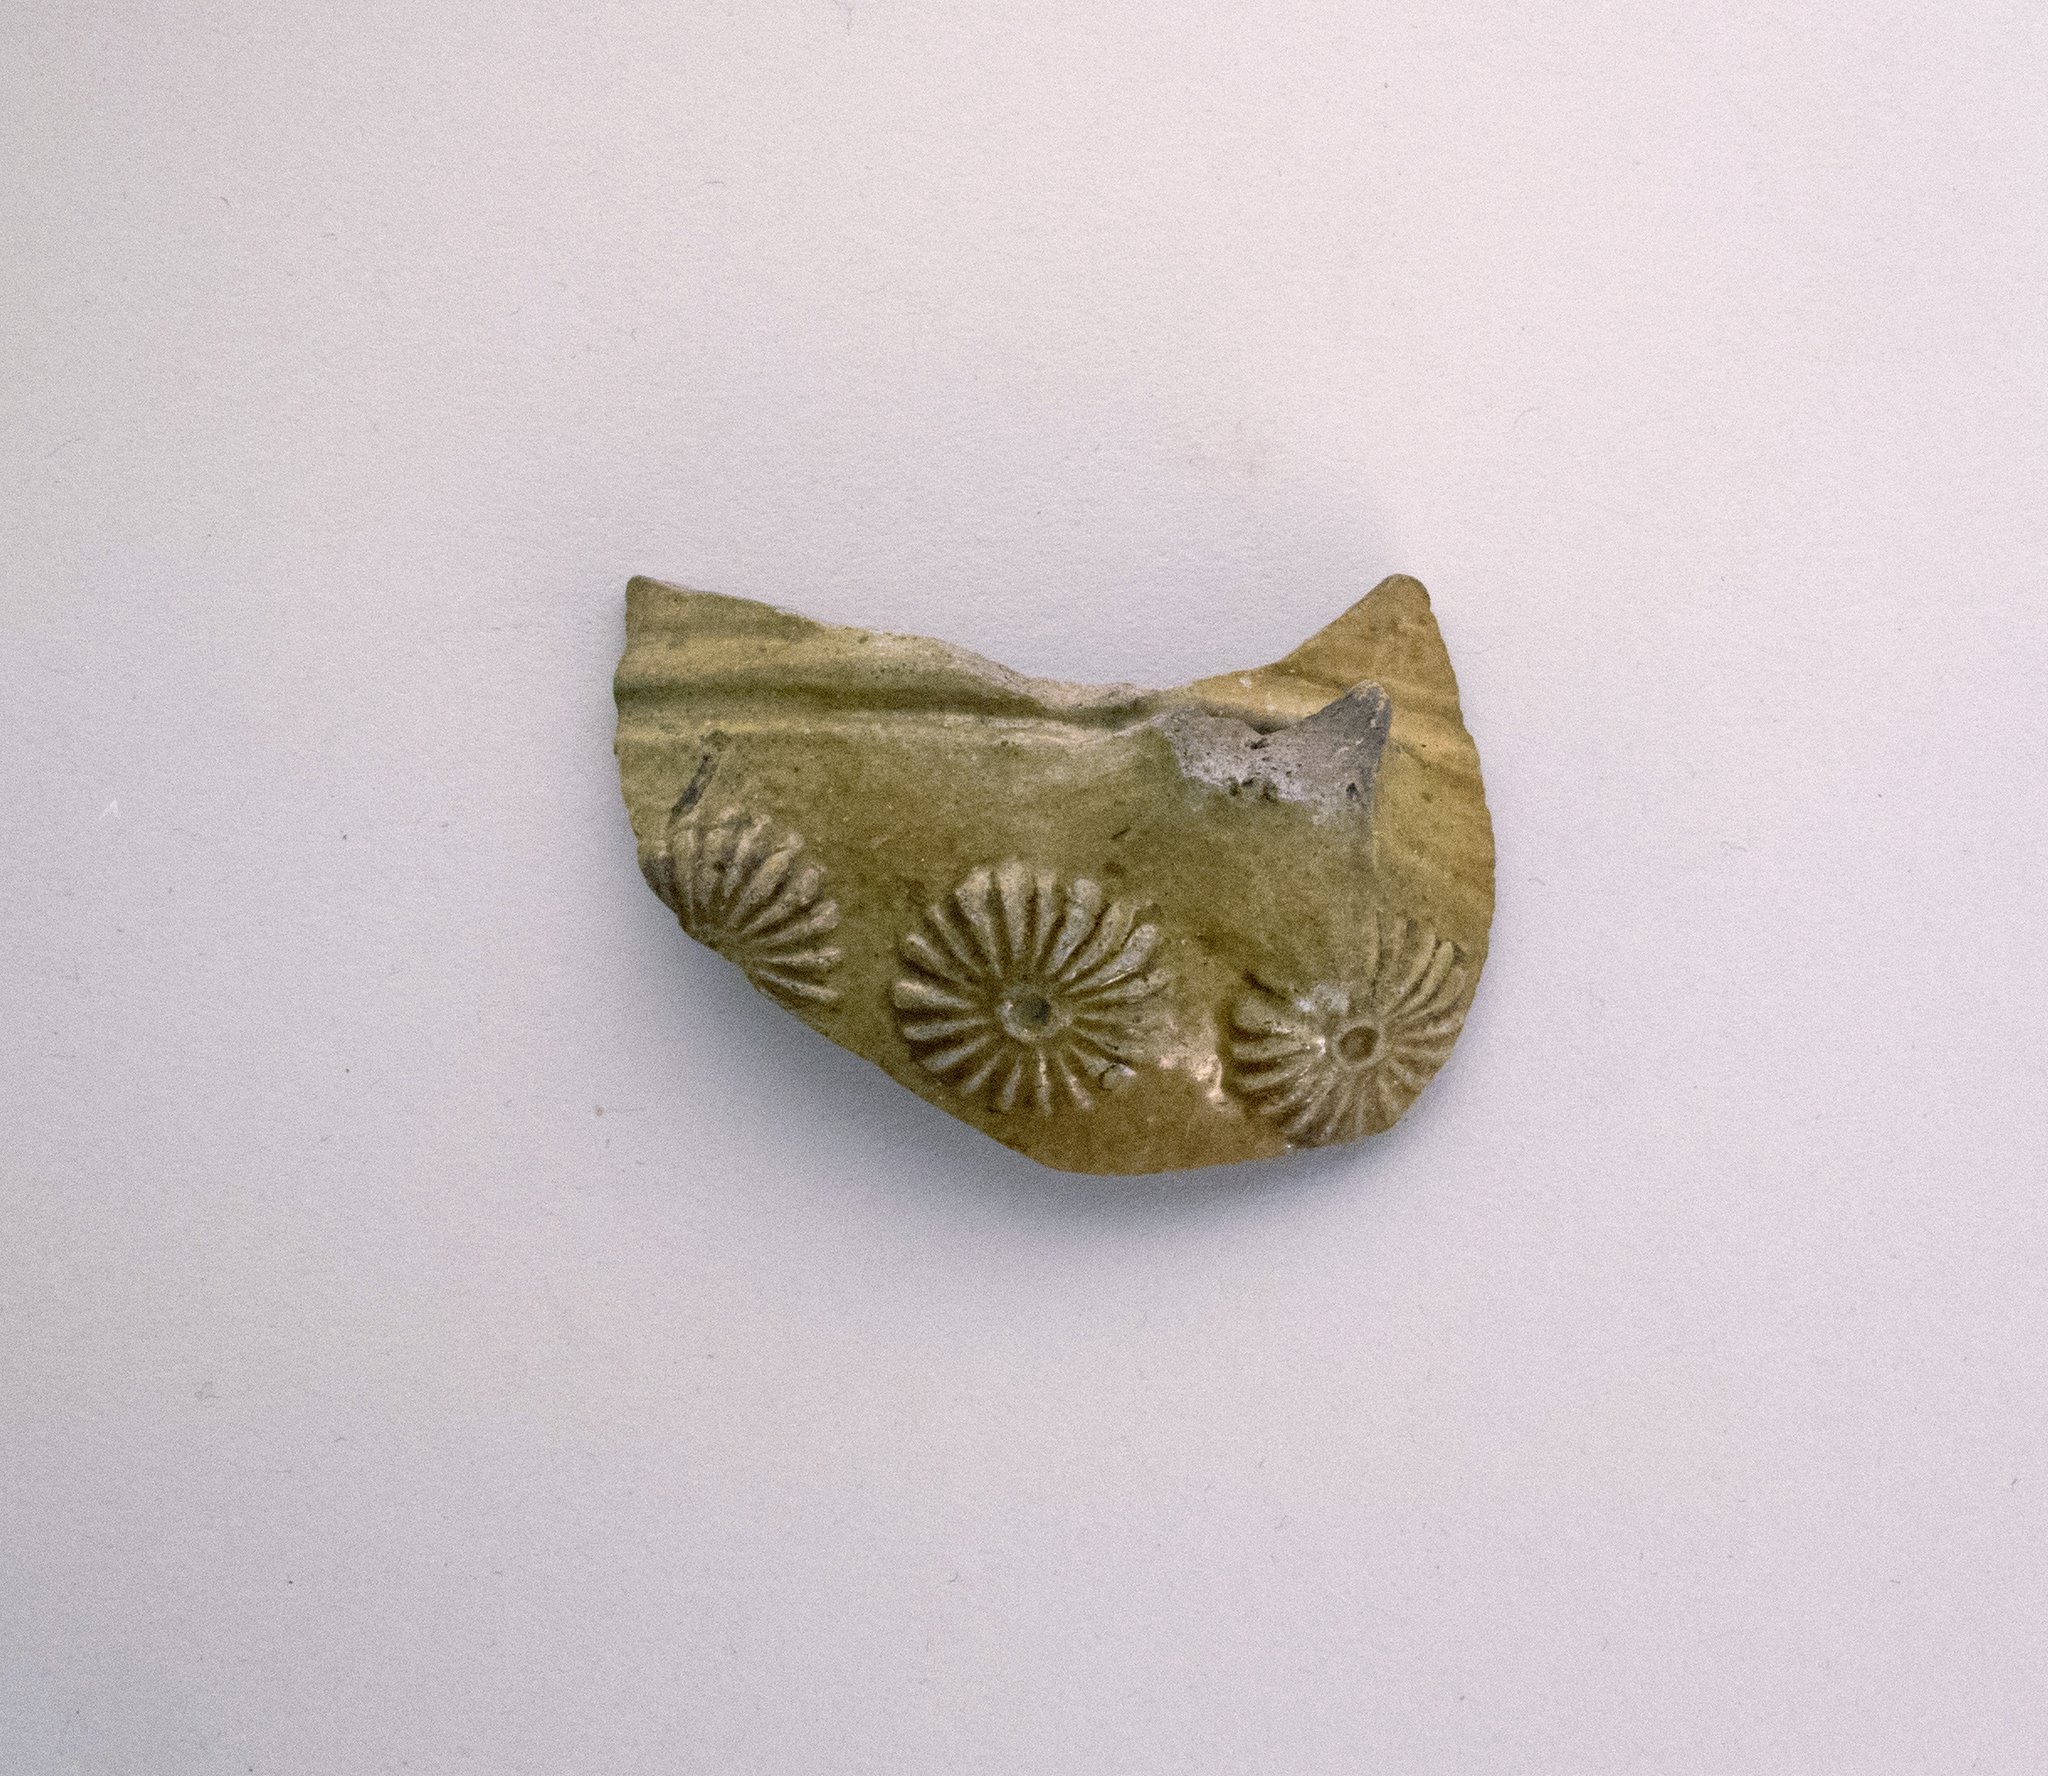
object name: vase fragment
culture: roman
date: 670 BCE-330 CE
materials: terracotta